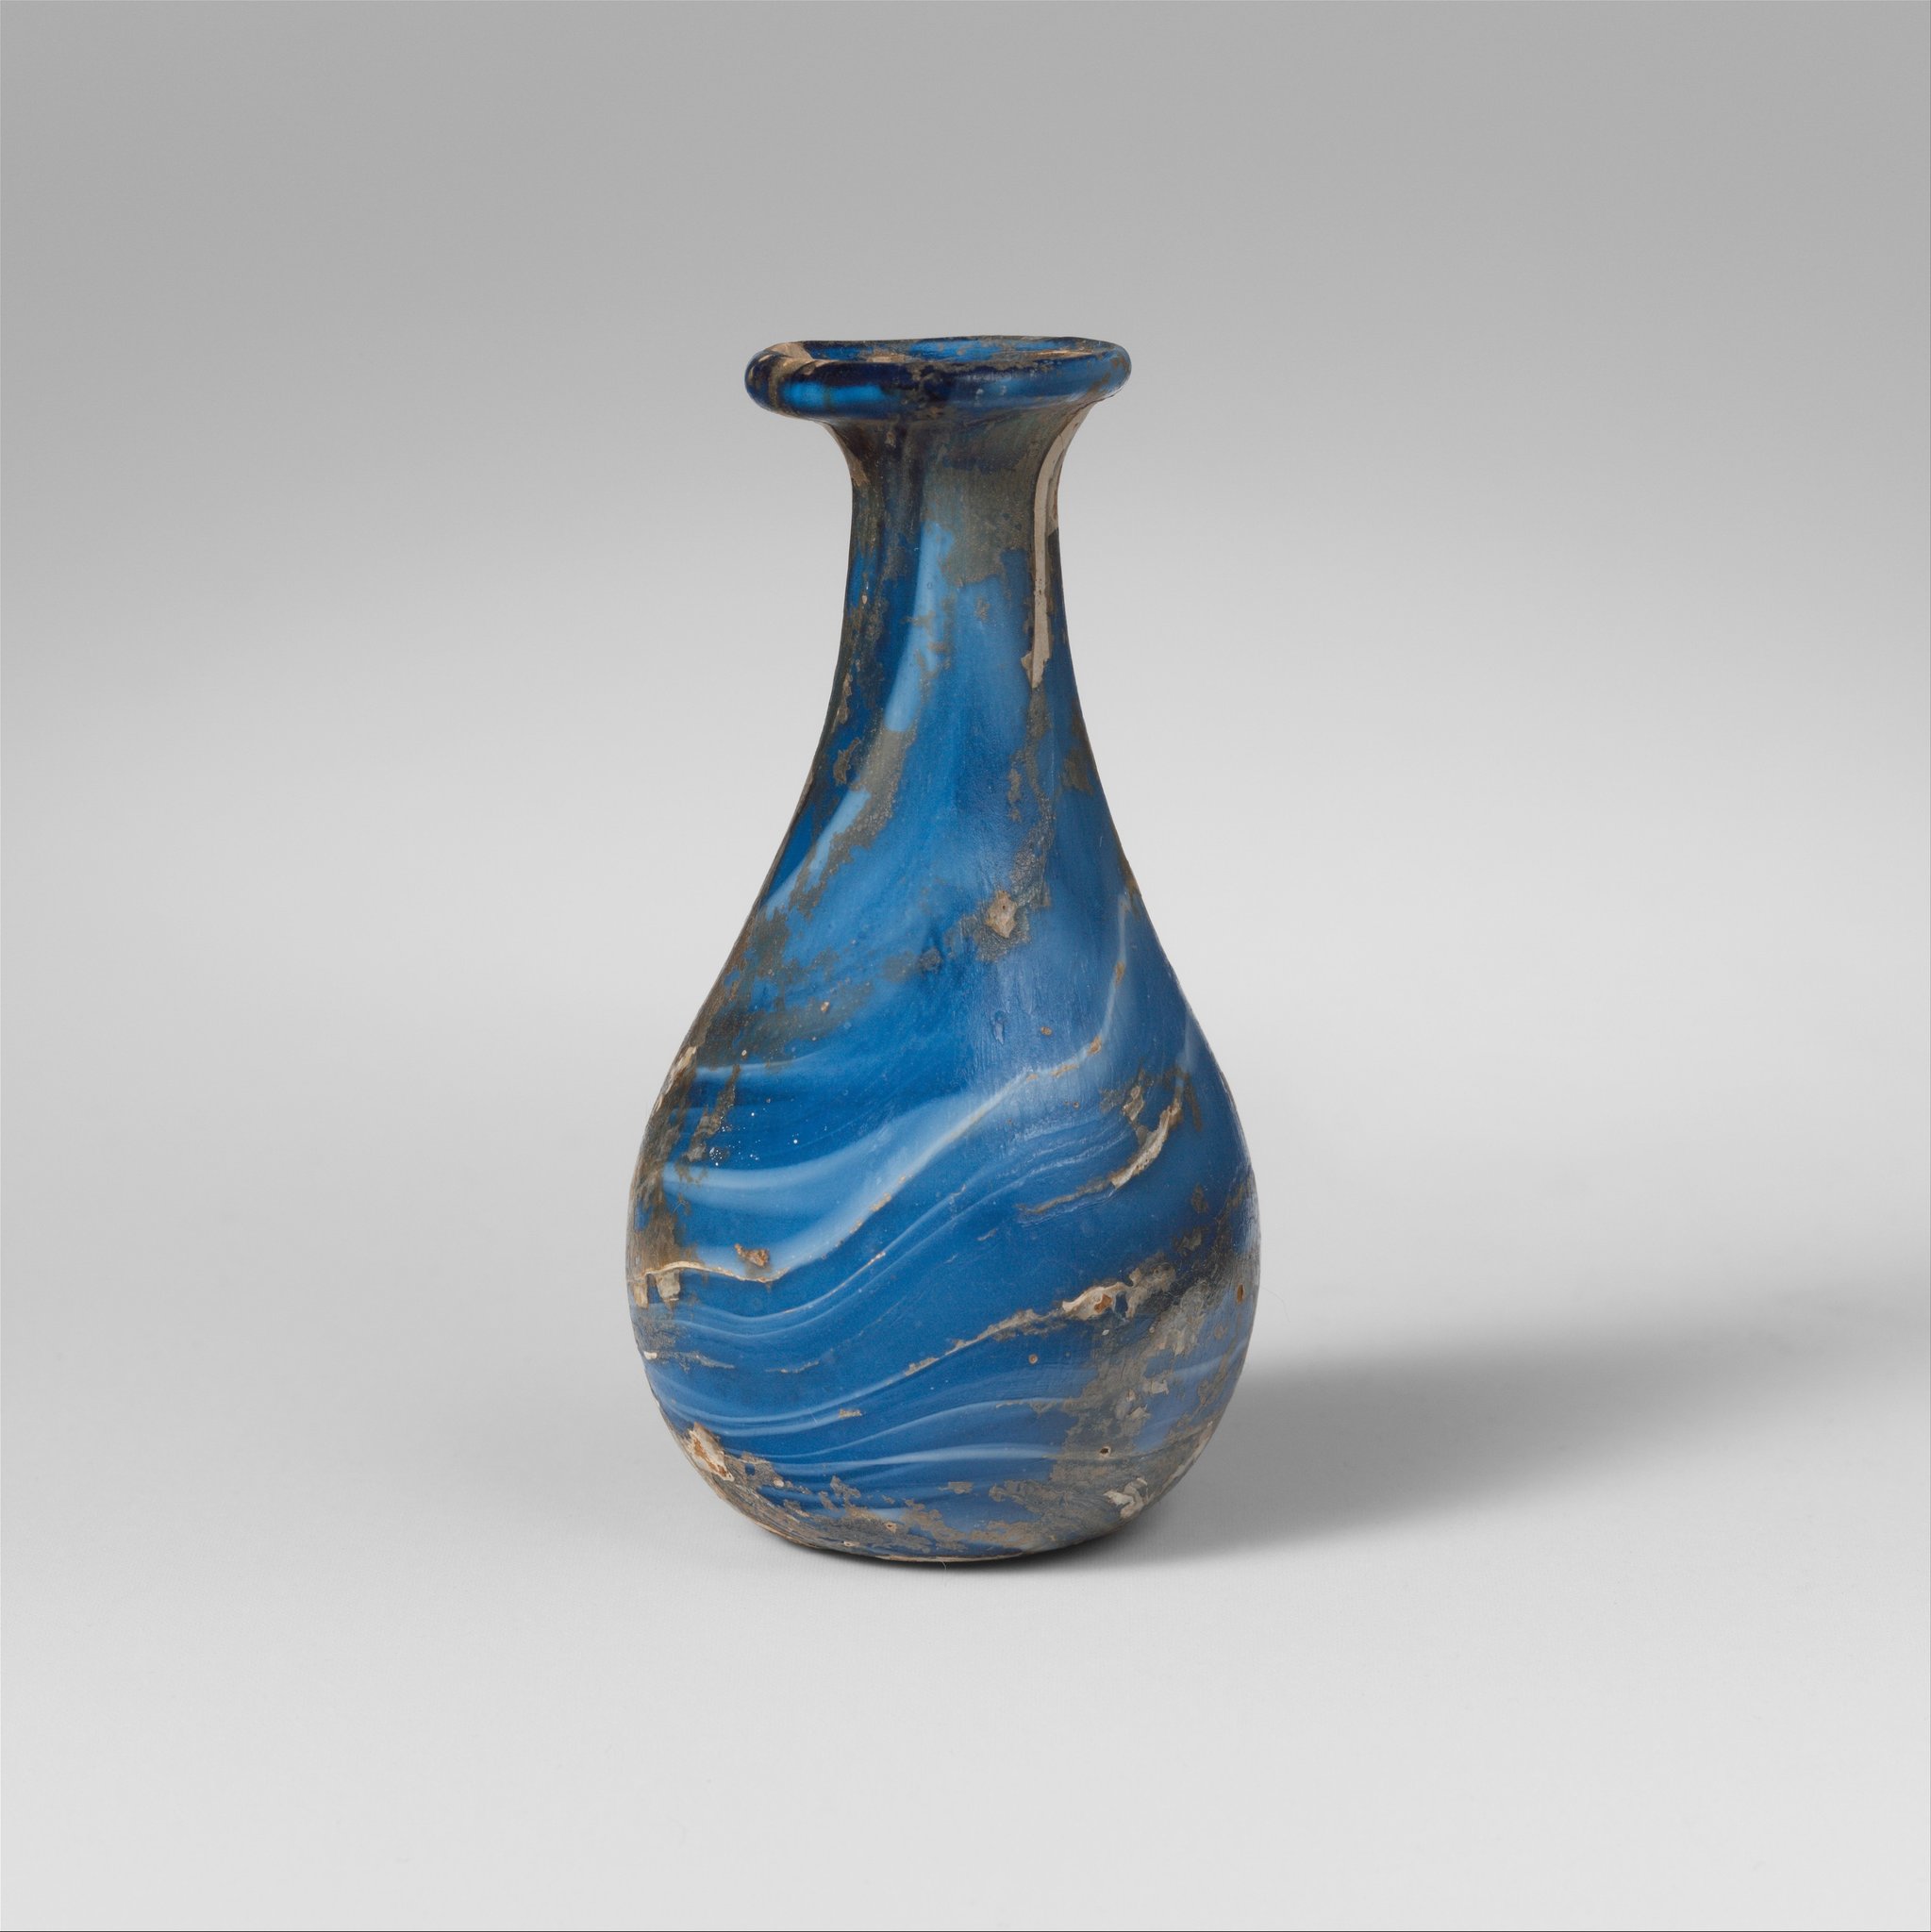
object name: perfume bottle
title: Marbled glass perfume bottle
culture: roman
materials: glass